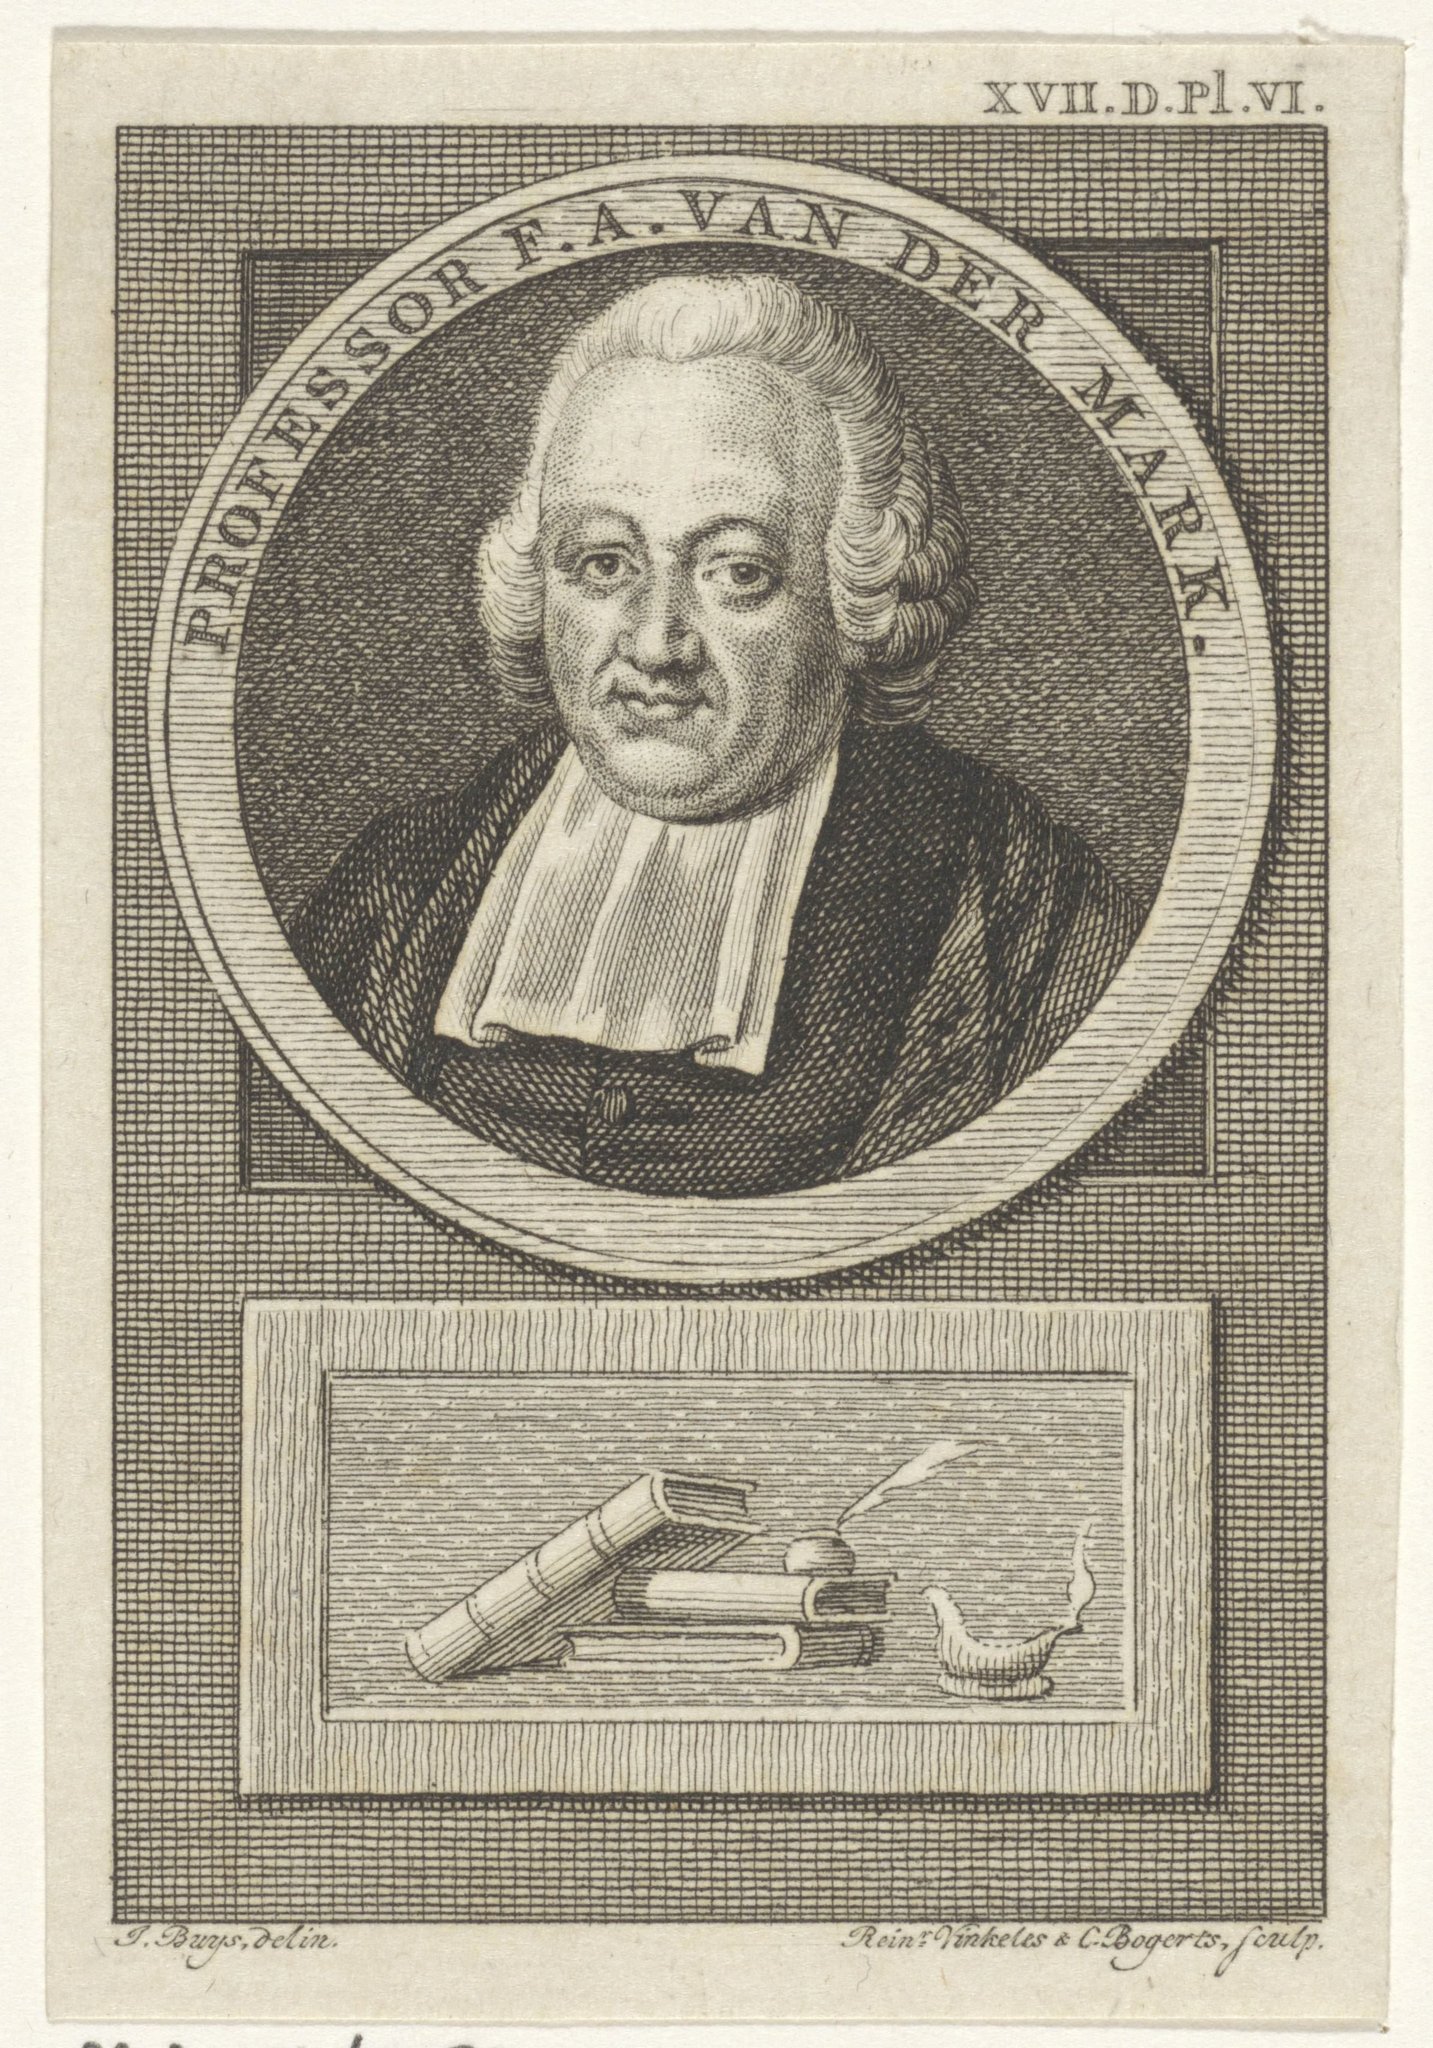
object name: book illustration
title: Portret van Frederik Adolph van der Marck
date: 1783-1795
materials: paper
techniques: engraving, etching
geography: amsterdam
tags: quill, ink-well, book, oil-lamp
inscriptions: collector's mark: Lugt 2228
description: Portret van Frederik Adolph van der Marck, professor te Groningen en Deventer. Onder het portret boeken en een inktpot met schrijfveer bij een olielamp. Rechtsboven: XVII.D.Pl.VI.